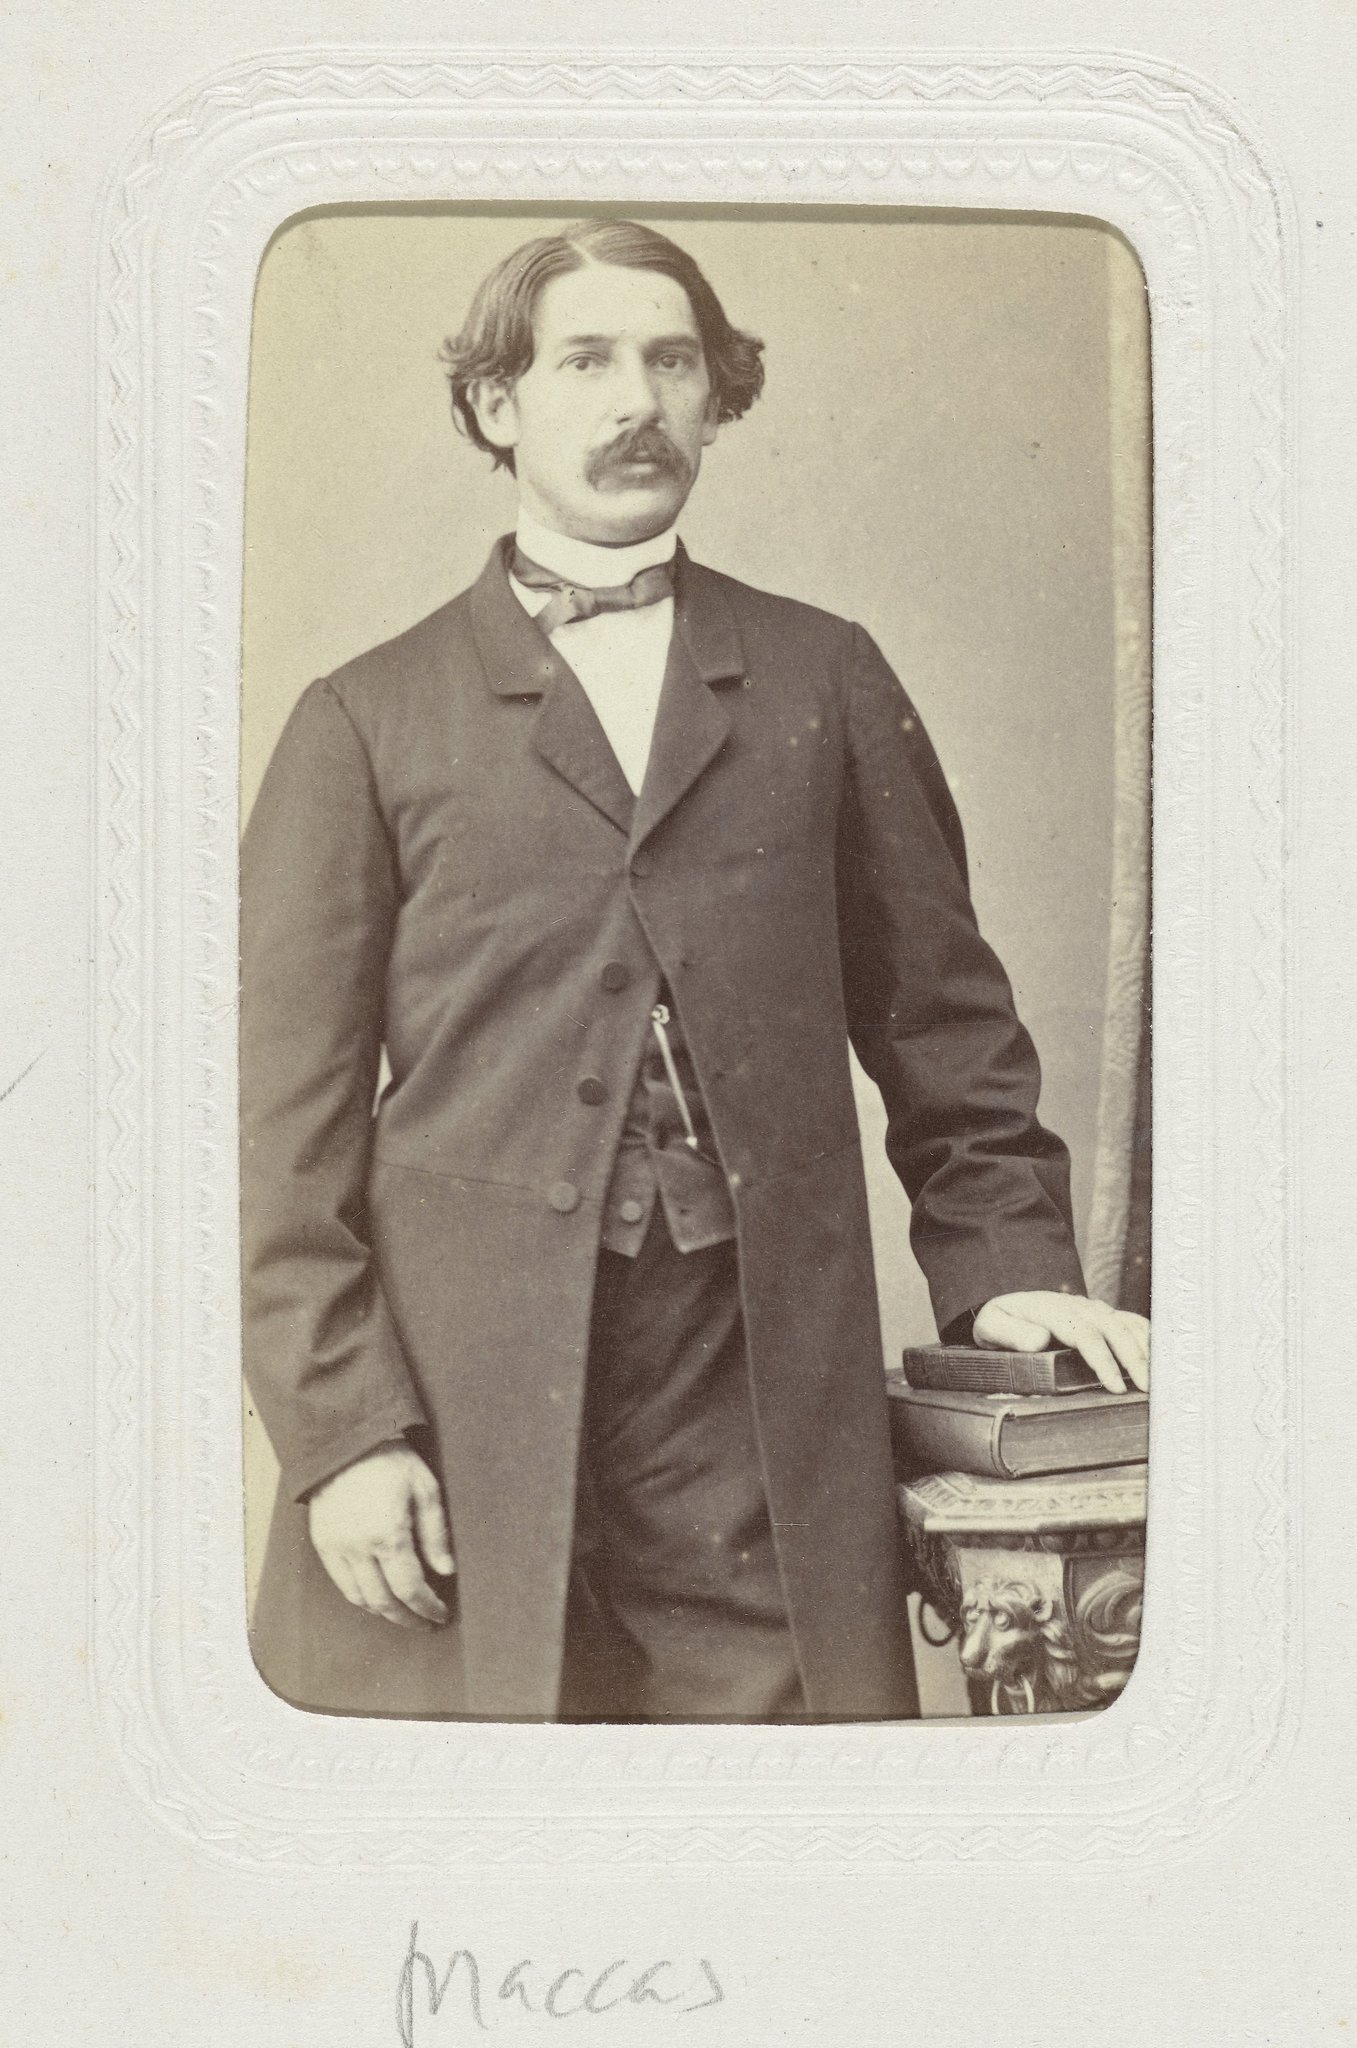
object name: carte de visite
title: Studioportret van een staande man met snor bij een tafel, hij draagt een lange jas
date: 1863-1866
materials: cardboard, paper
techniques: albumen print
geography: istanbul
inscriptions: name: ‘maccas’, stamp: ‘Abdullah freres Constantinopel’